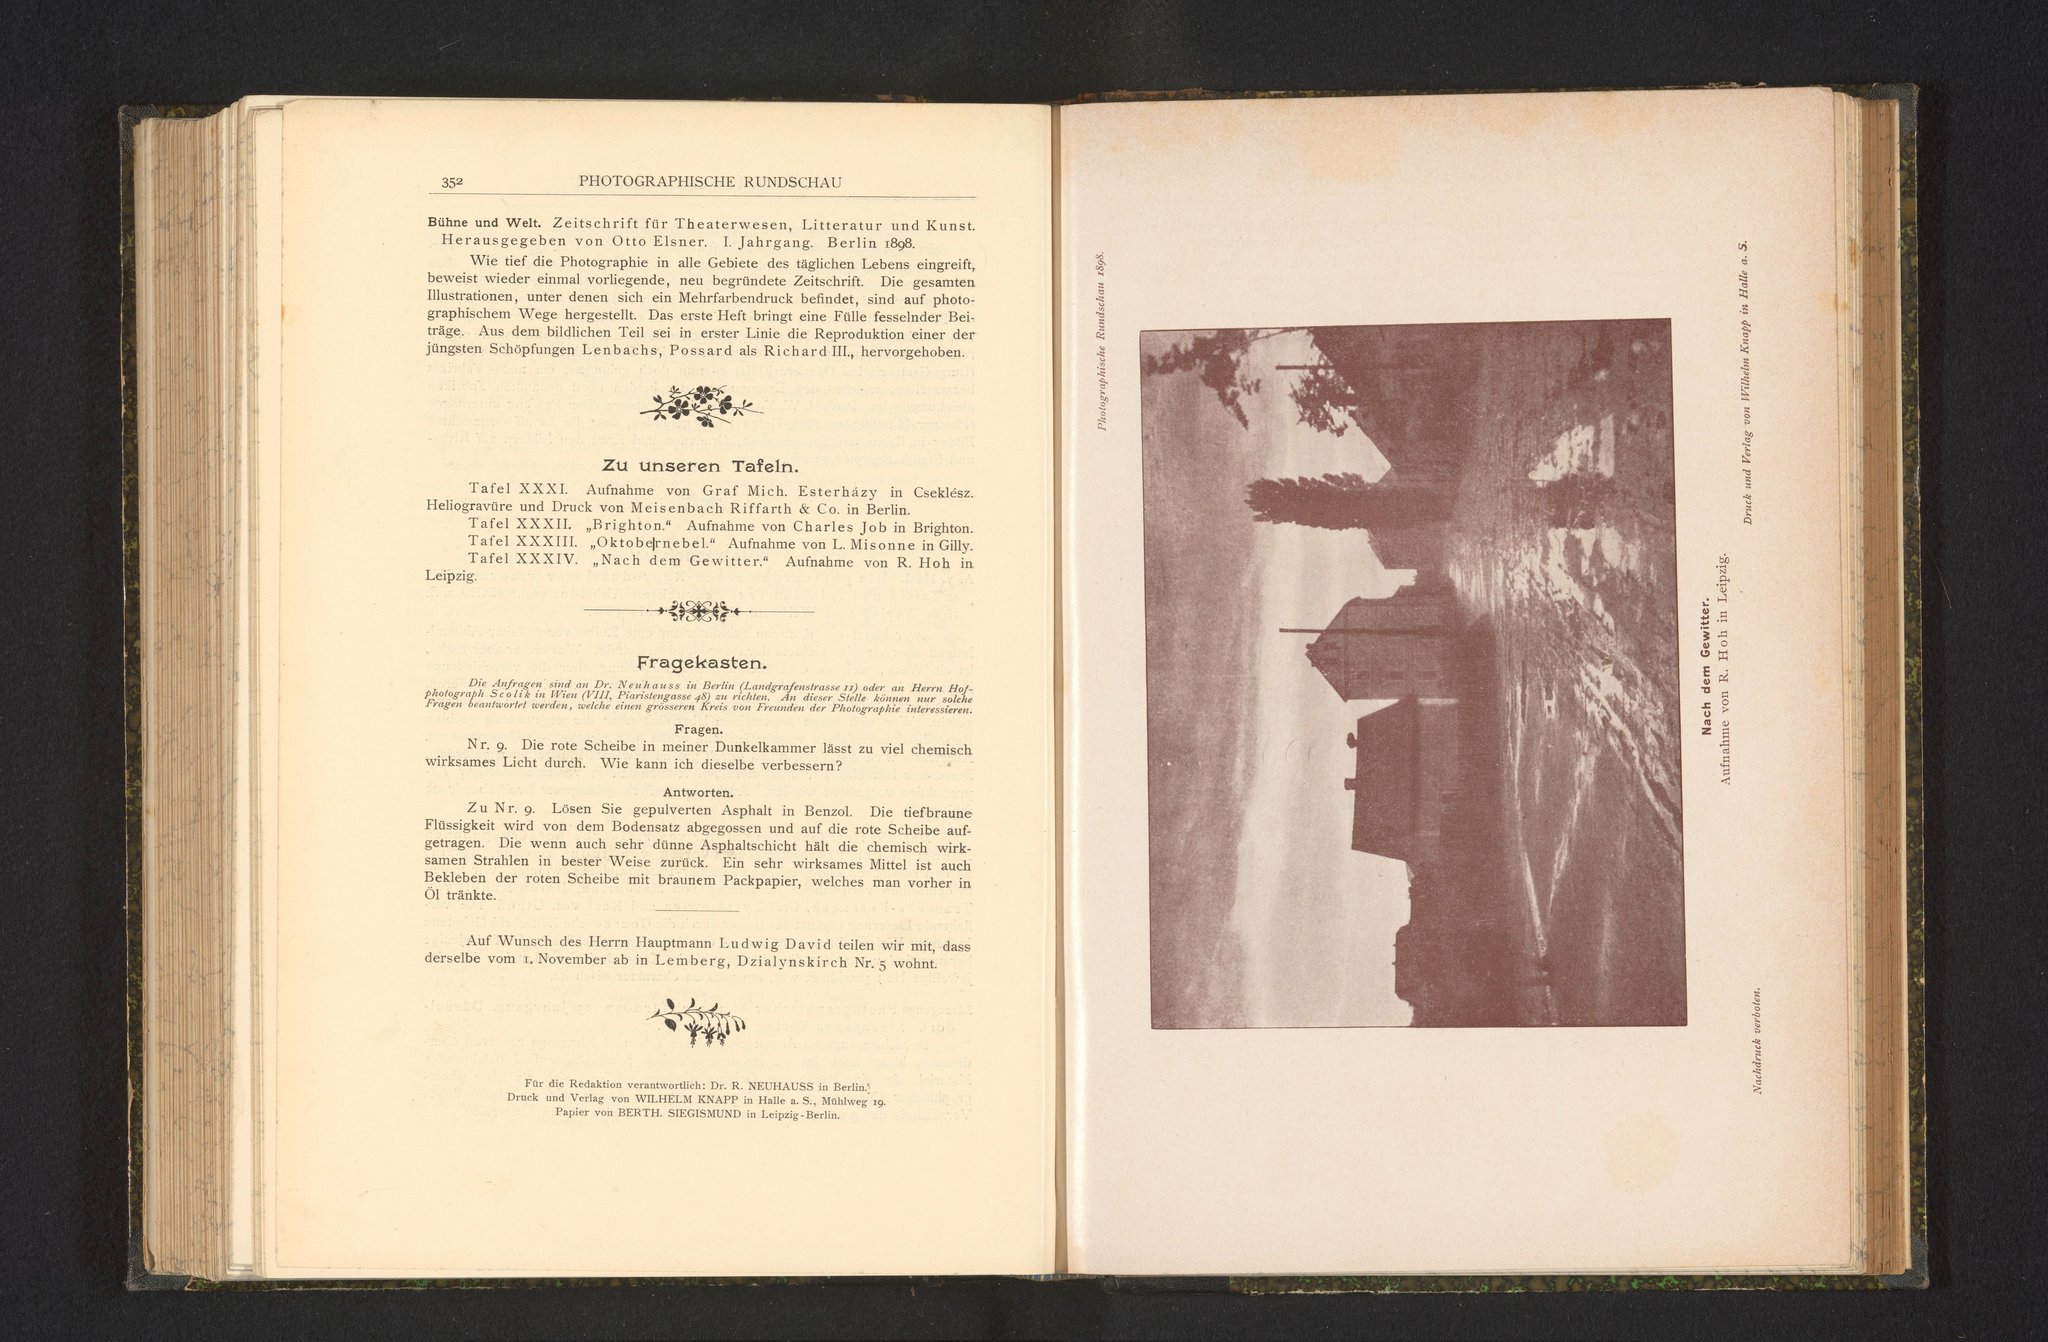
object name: page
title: Nach dem gewitter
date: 1893-1898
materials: paper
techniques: autotype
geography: halle an der saale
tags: city-view, and landscape with man-made constructions